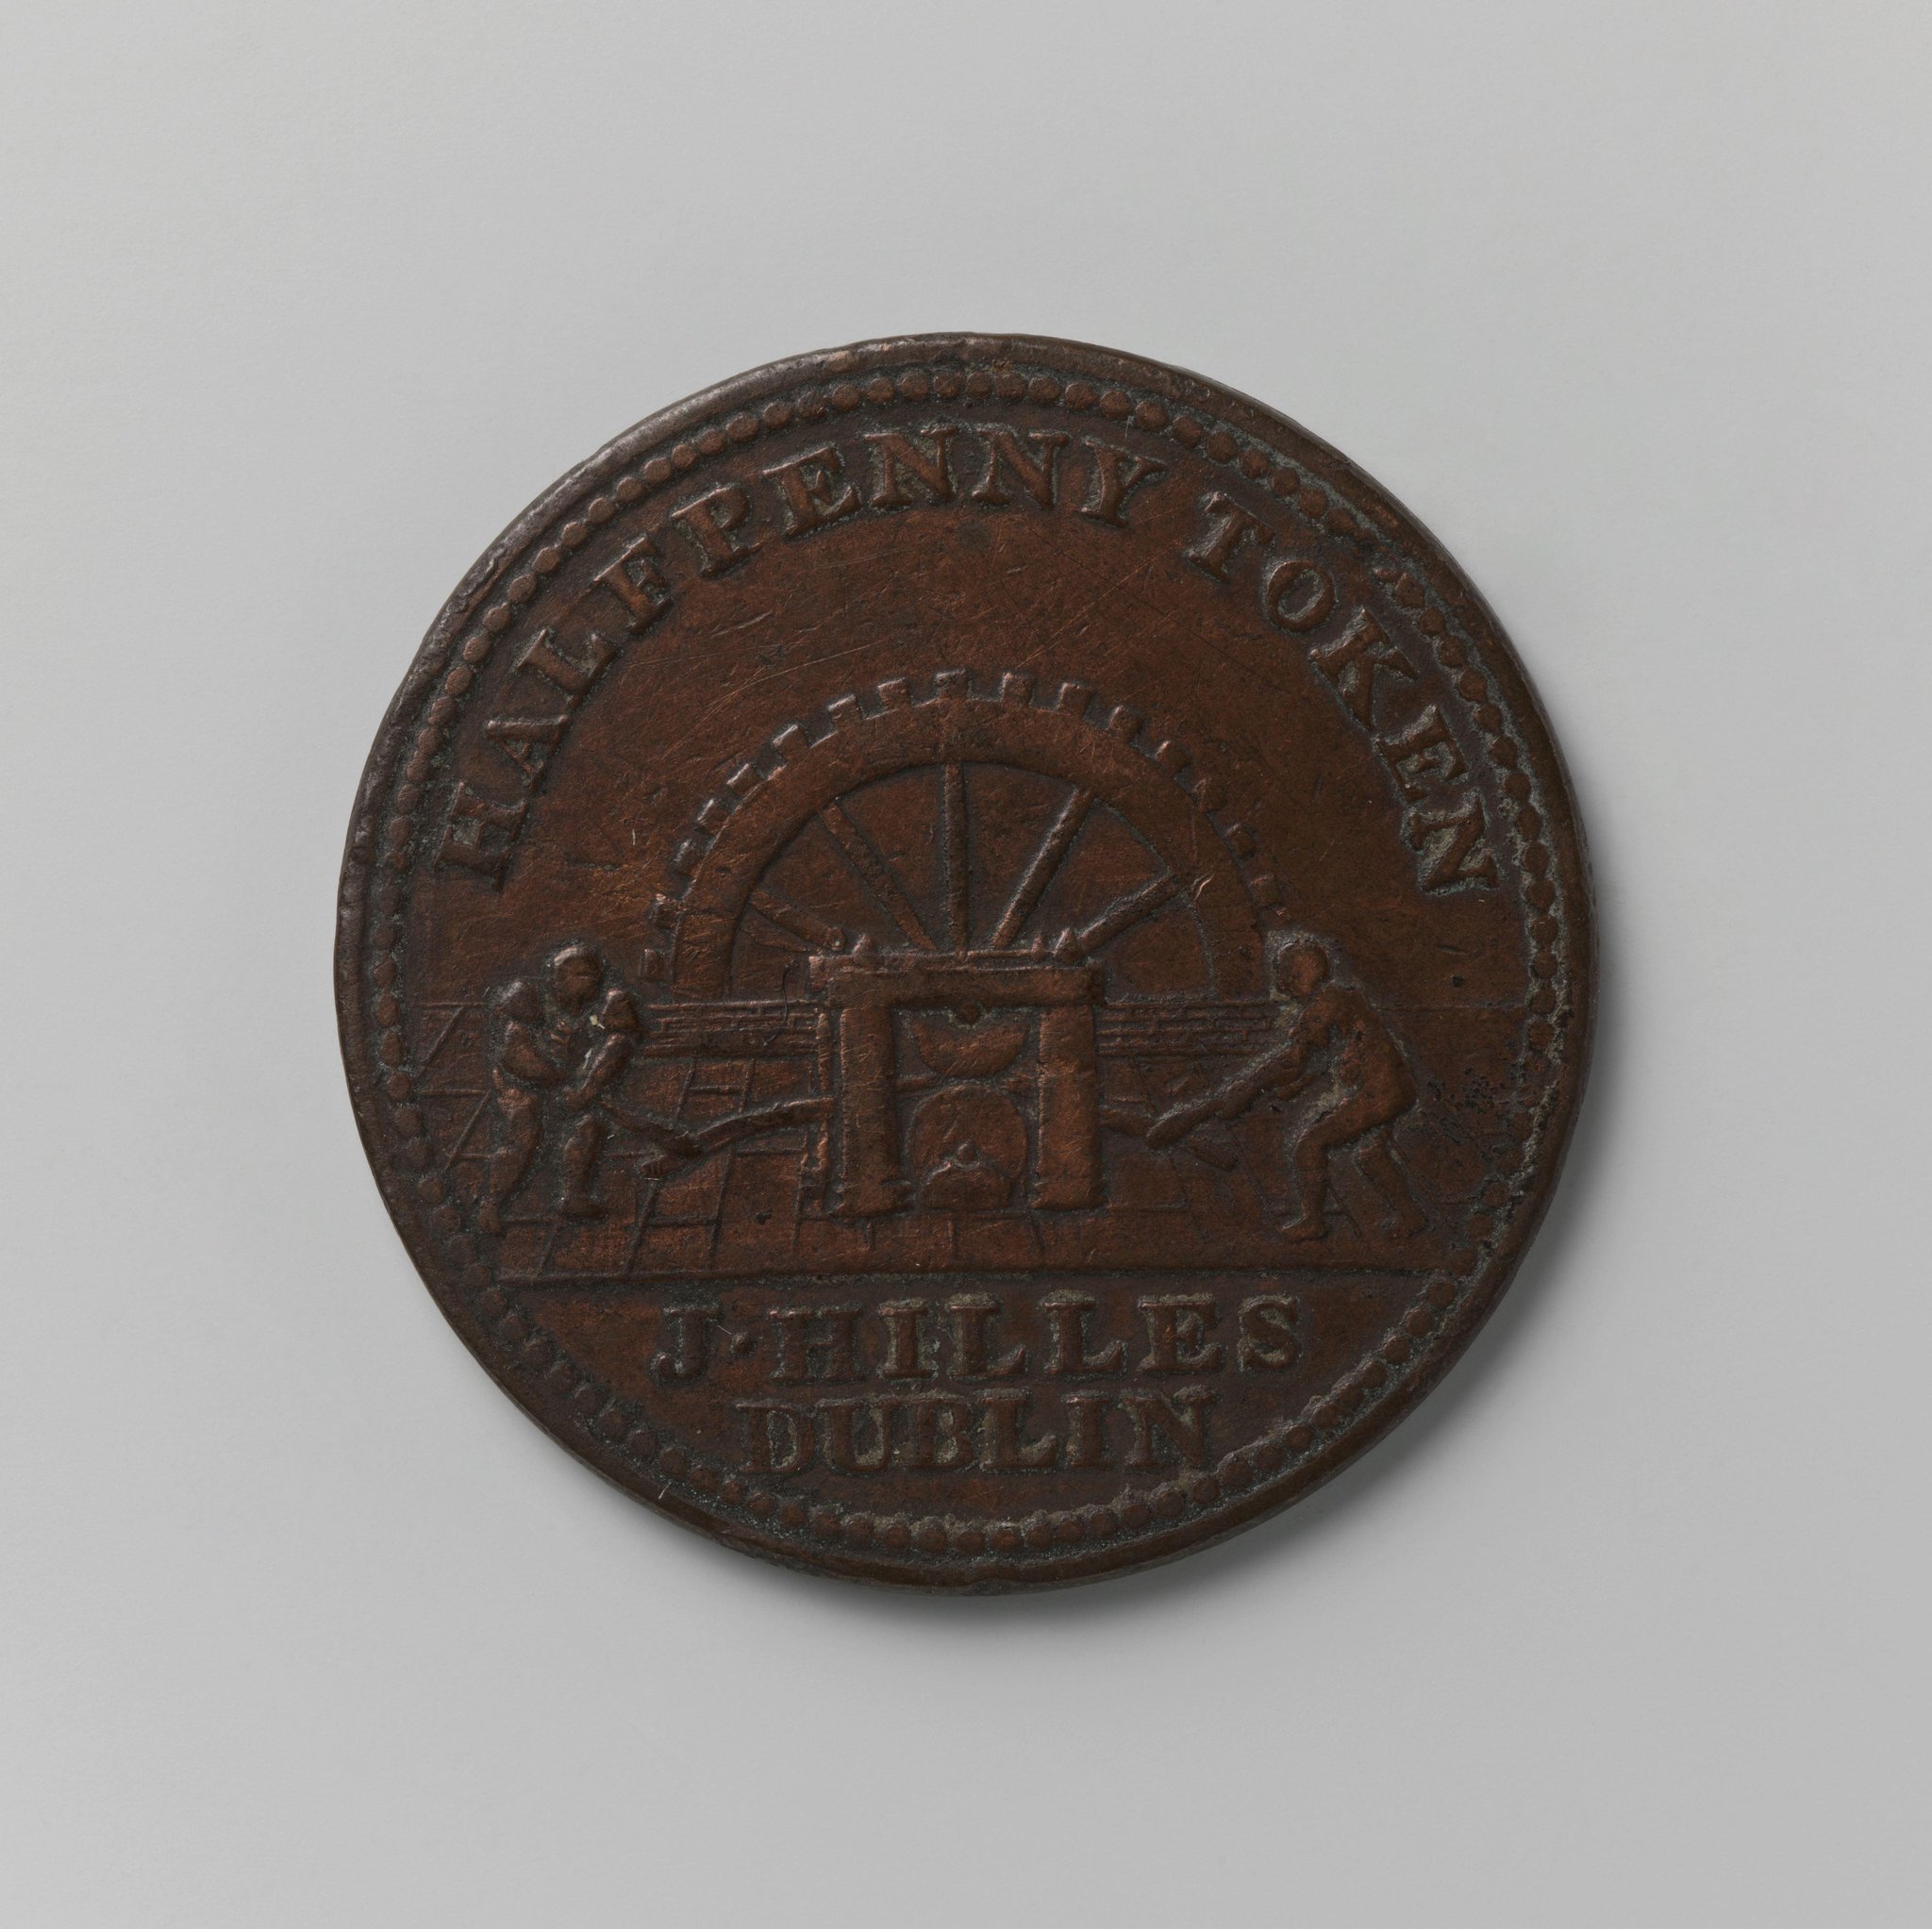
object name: halve penny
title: ½ penny-token, Dublin, Ierland, 1813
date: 1813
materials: copper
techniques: striking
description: Koperen particuliere munt. Voorzijde: plaatperserij met twee arbeiders. Daarboven waarde-aanduiding. In afsnede jaartal. Keerzijde: tak met klaverblaadjes. Daaronder jaartal. Kabelrand.